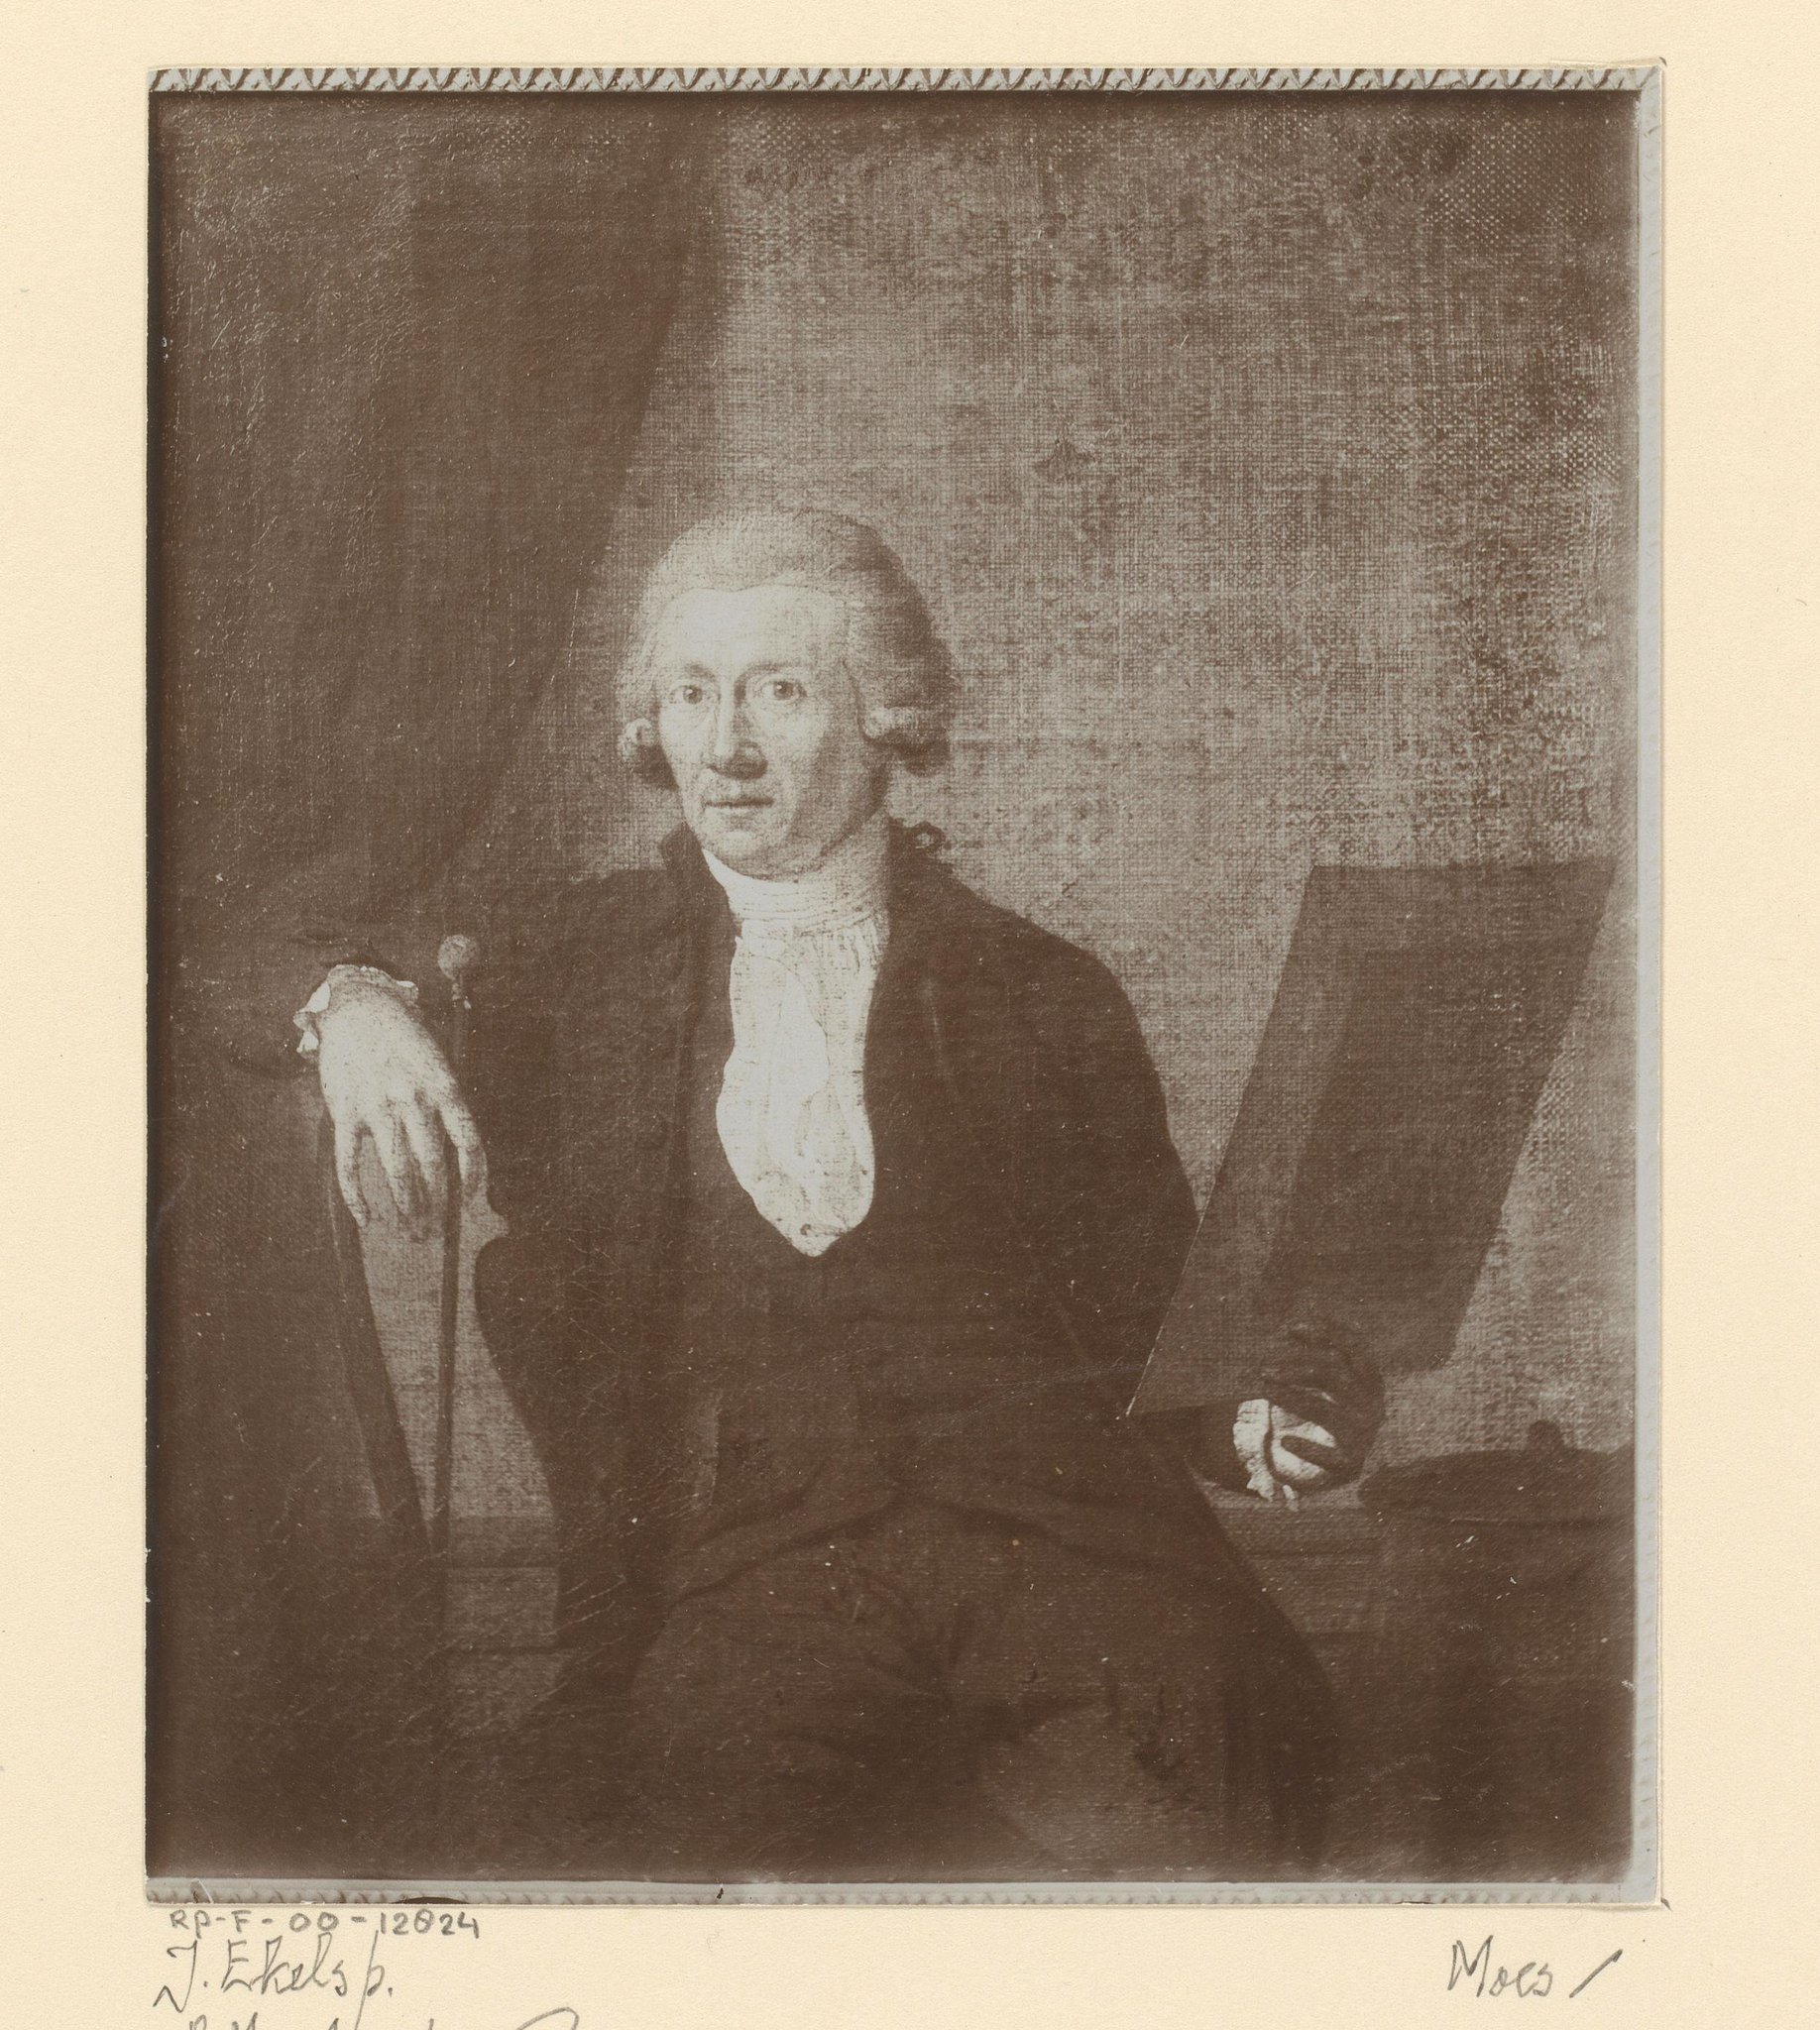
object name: reproduction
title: Fotoreproductie van een geschilderd portret van Egbert van Drielst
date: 1900-1915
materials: paper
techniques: collodion silver print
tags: draughtsman, egbert van drielst, portrait, self-portrait of artist, picture, painting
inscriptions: inscription: ‘No 305, cat 1920/ portret van Egbert van/ Drielst/ door?/ Ekels./ Semplonius foto’